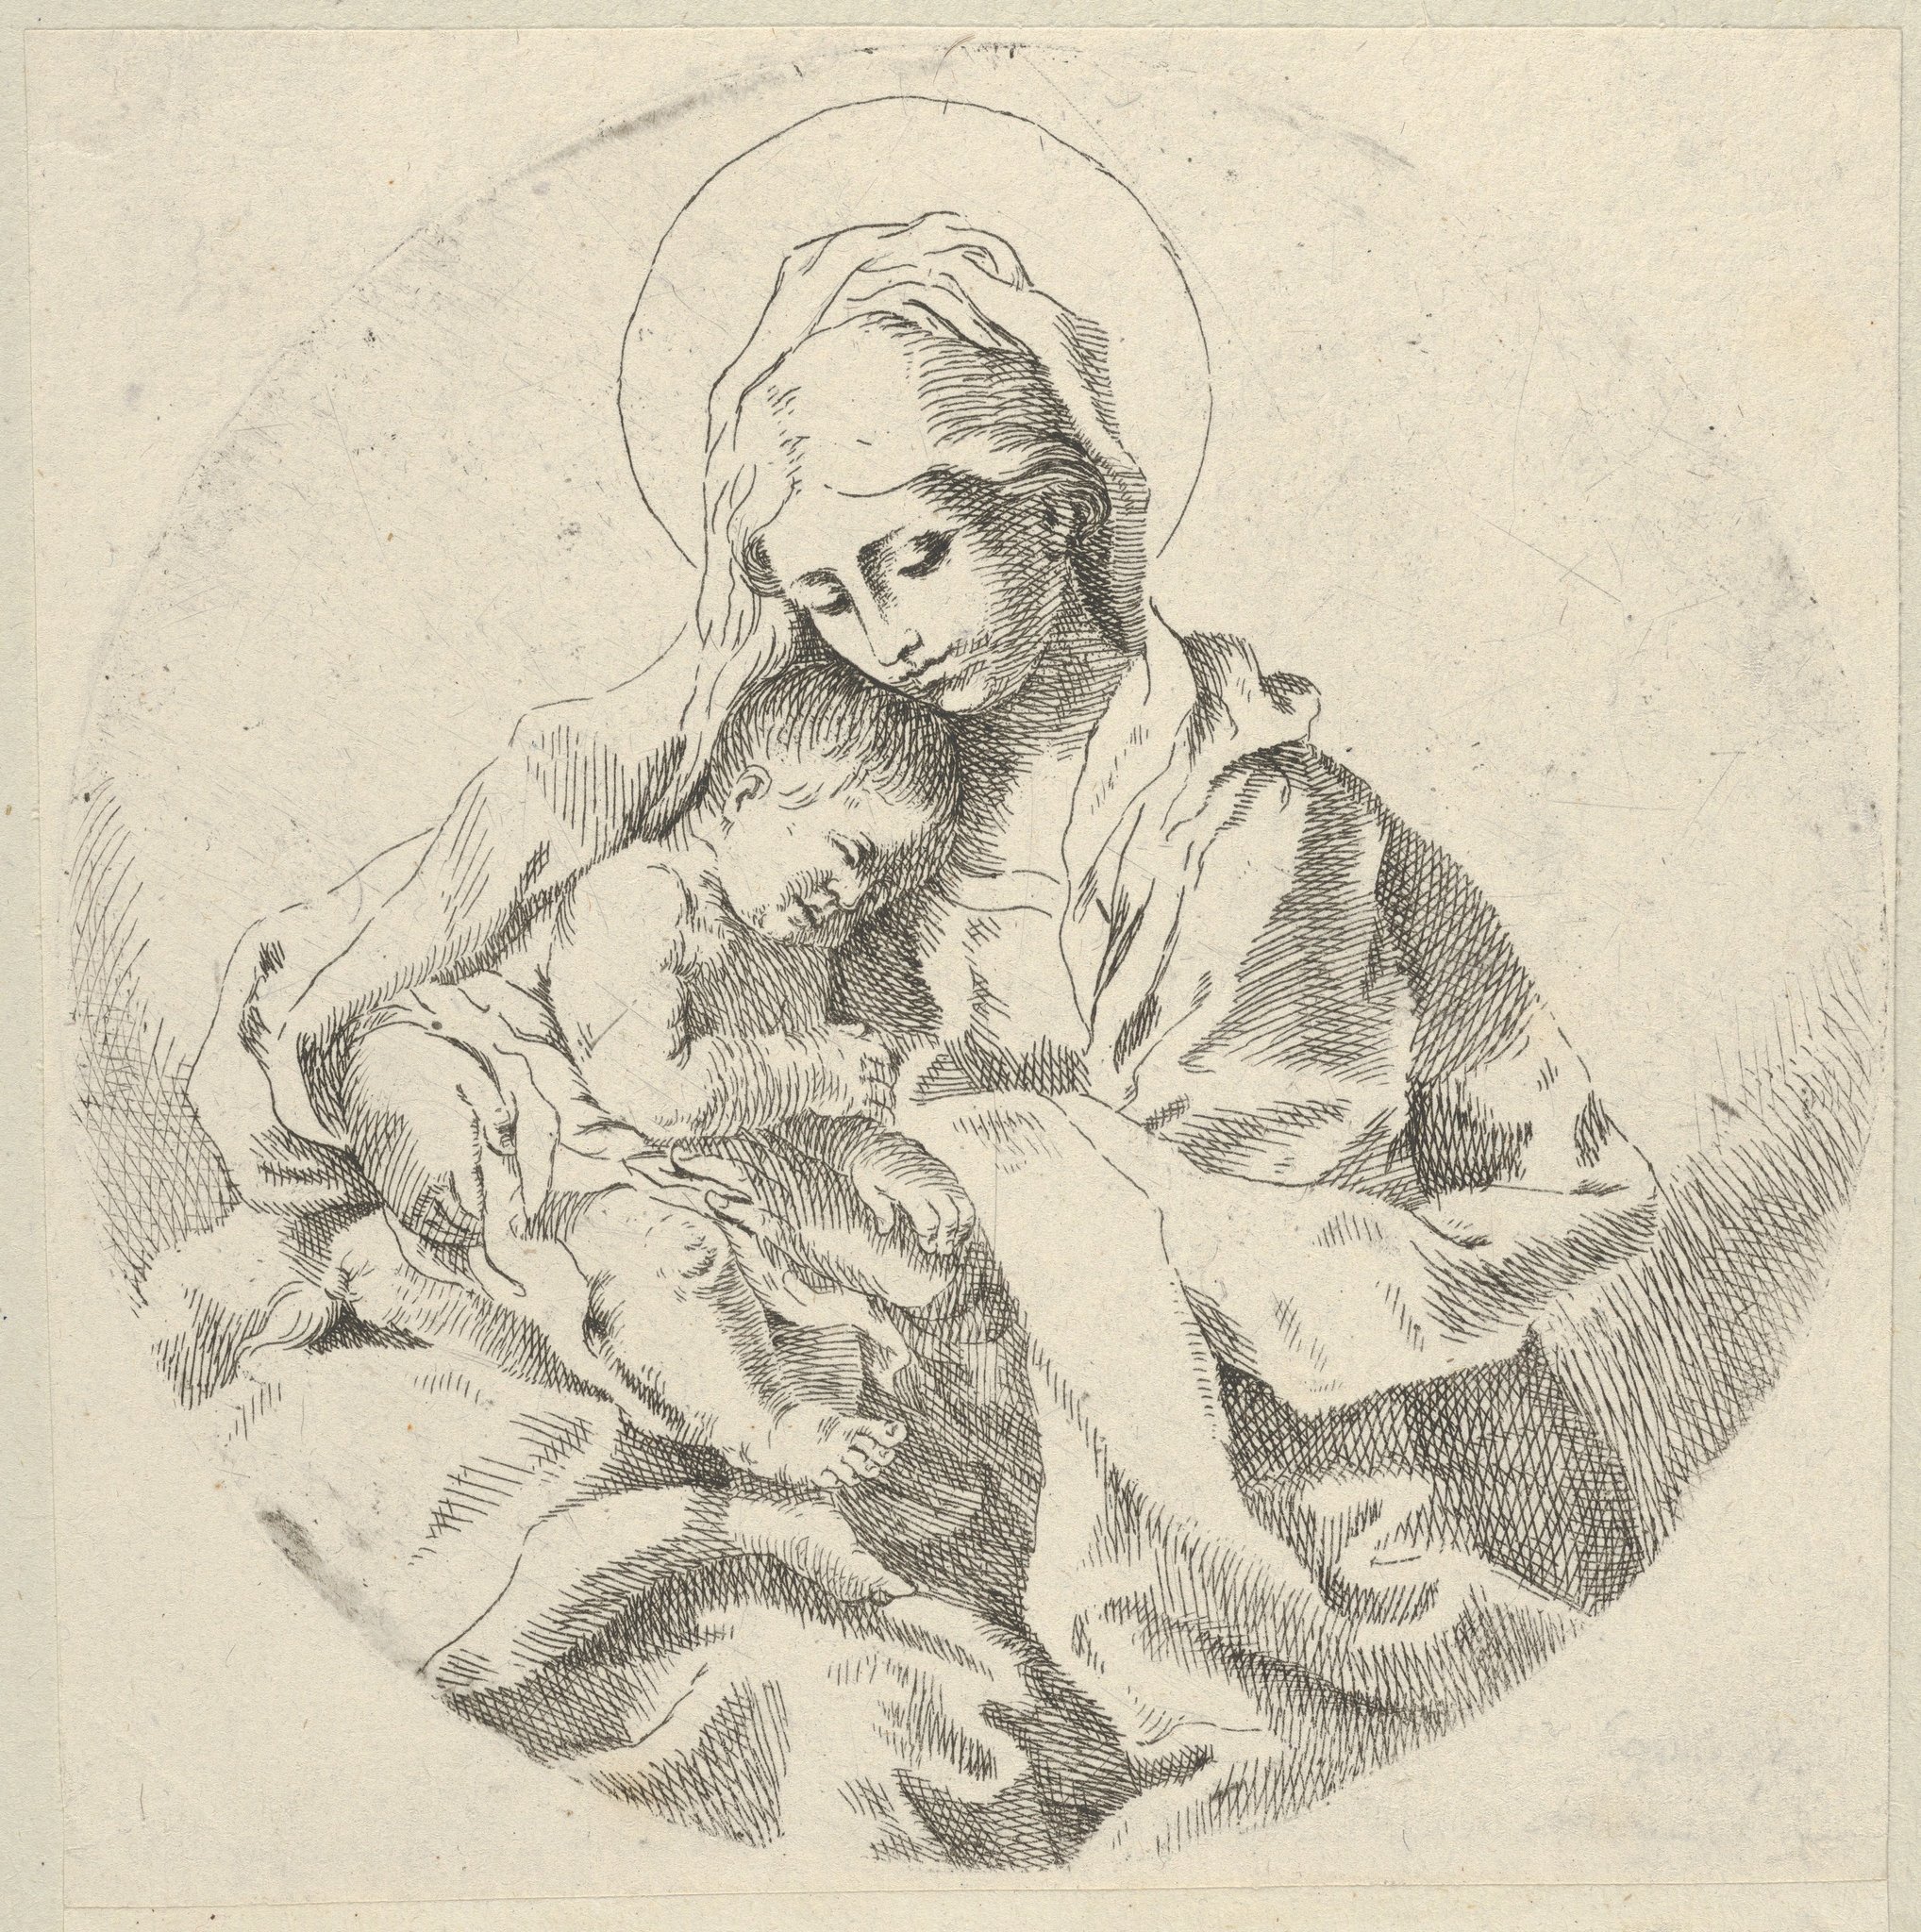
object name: print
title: The Virgin holding the infant Christ, a circular composition, after Reni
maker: anonymous, 17th century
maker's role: artist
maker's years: 1600-1700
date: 1600-1640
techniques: etching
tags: madonna and child,virgin mary,jesus